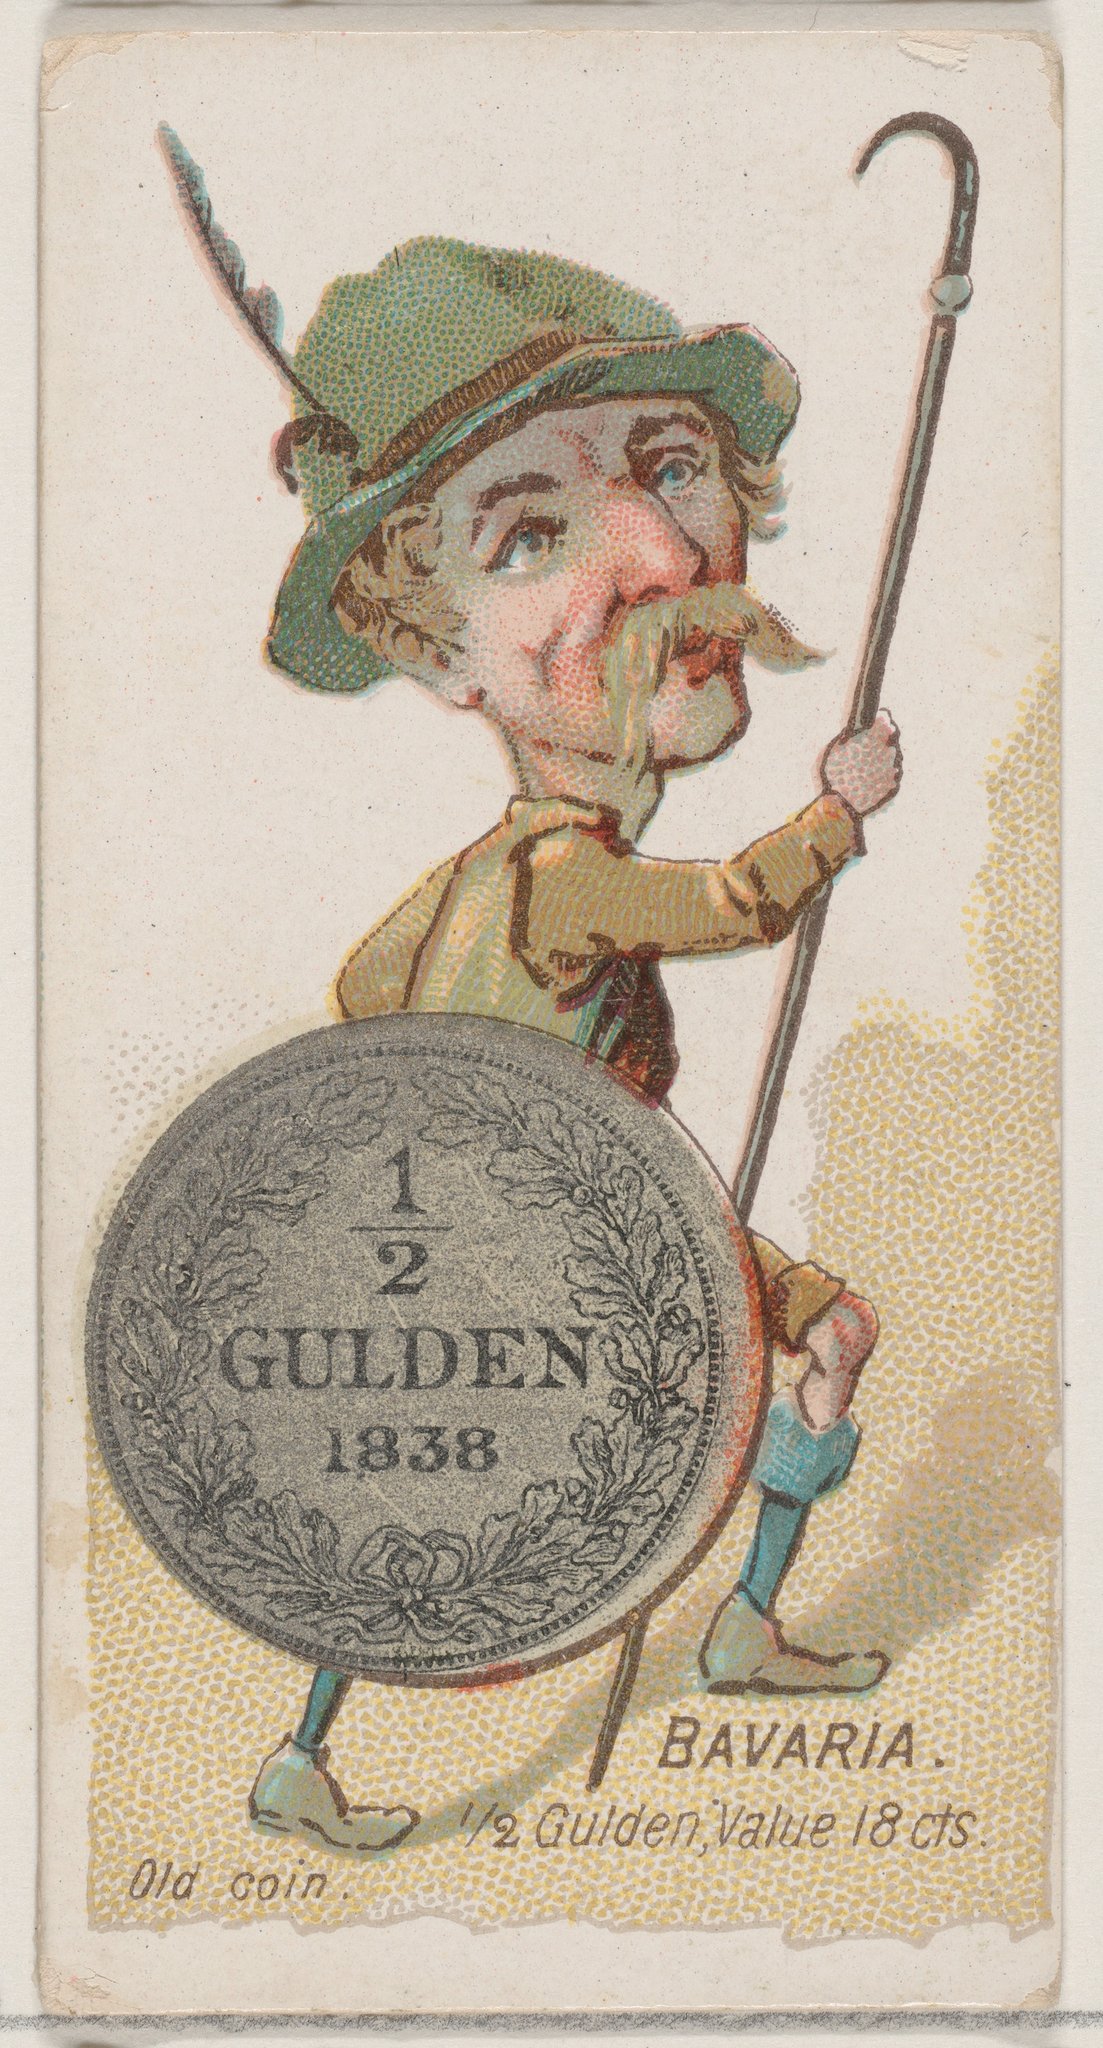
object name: print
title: Bavaria, 1/2 Gulden, from the series Coins of All Nations (N72, variation 1) for Duke brand cigarettes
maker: w. duke, sons & co.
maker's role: publisher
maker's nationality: american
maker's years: 1870-1920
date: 1889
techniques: color lithograph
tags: men,coins